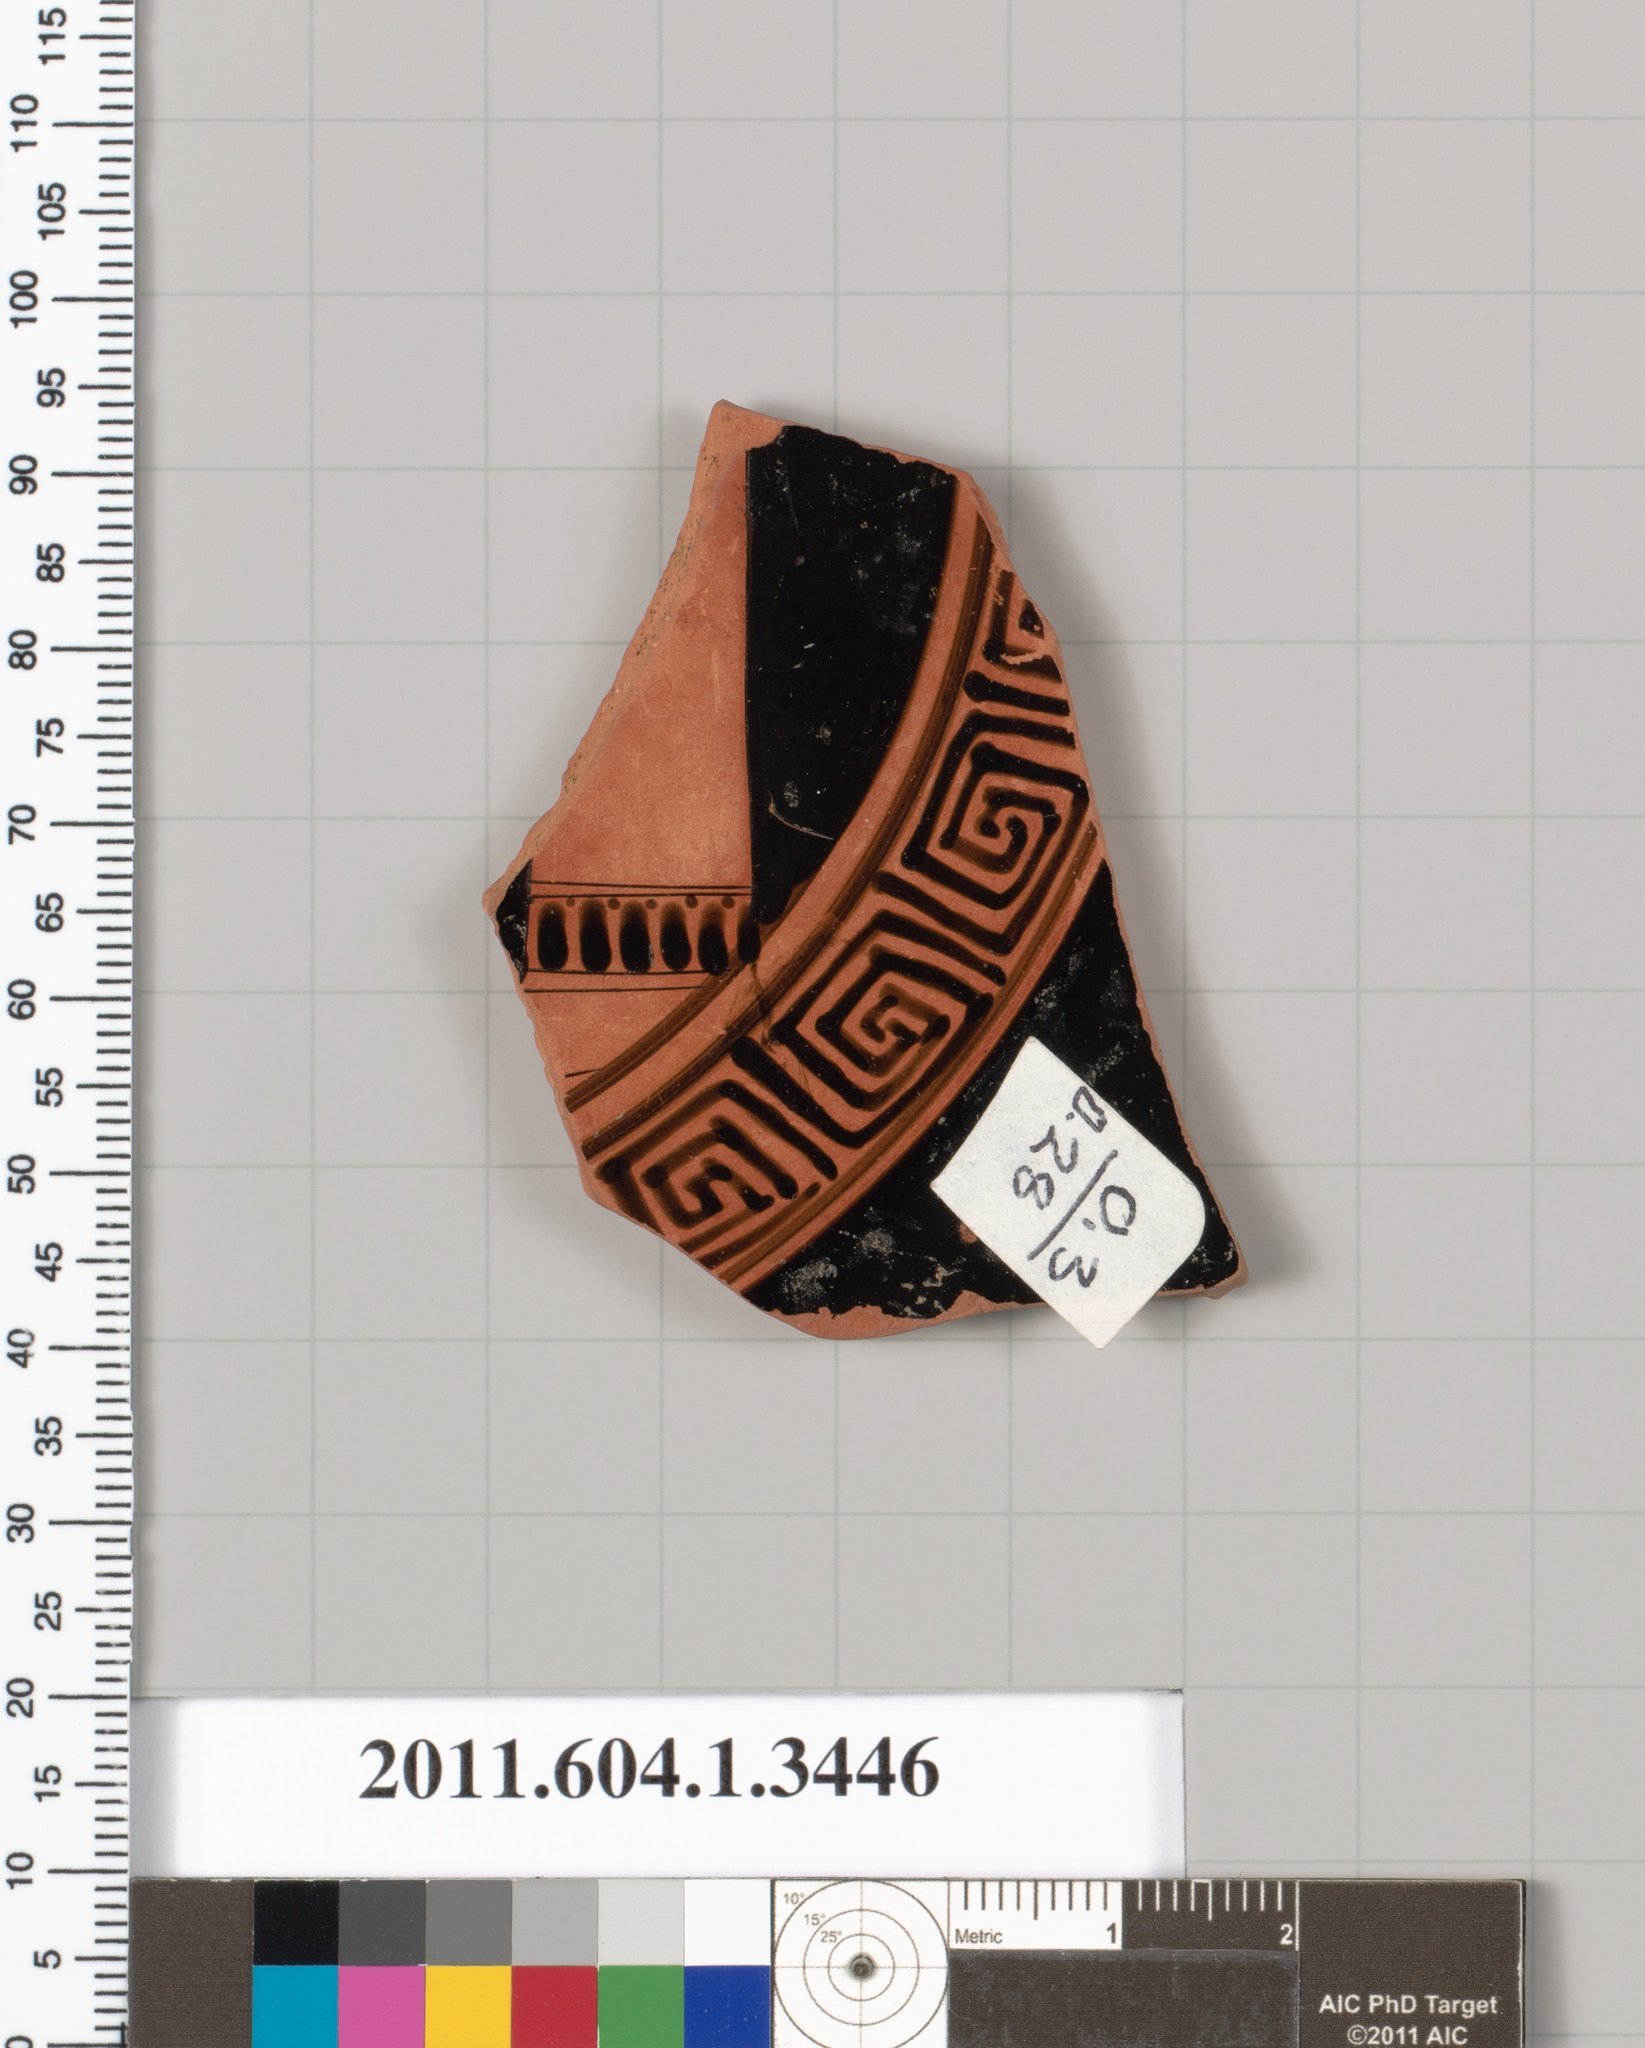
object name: kylix fragment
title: Terracotta fragment of a kylix (drinking cup)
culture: greek, attic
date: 475-451 BCE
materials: terracotta